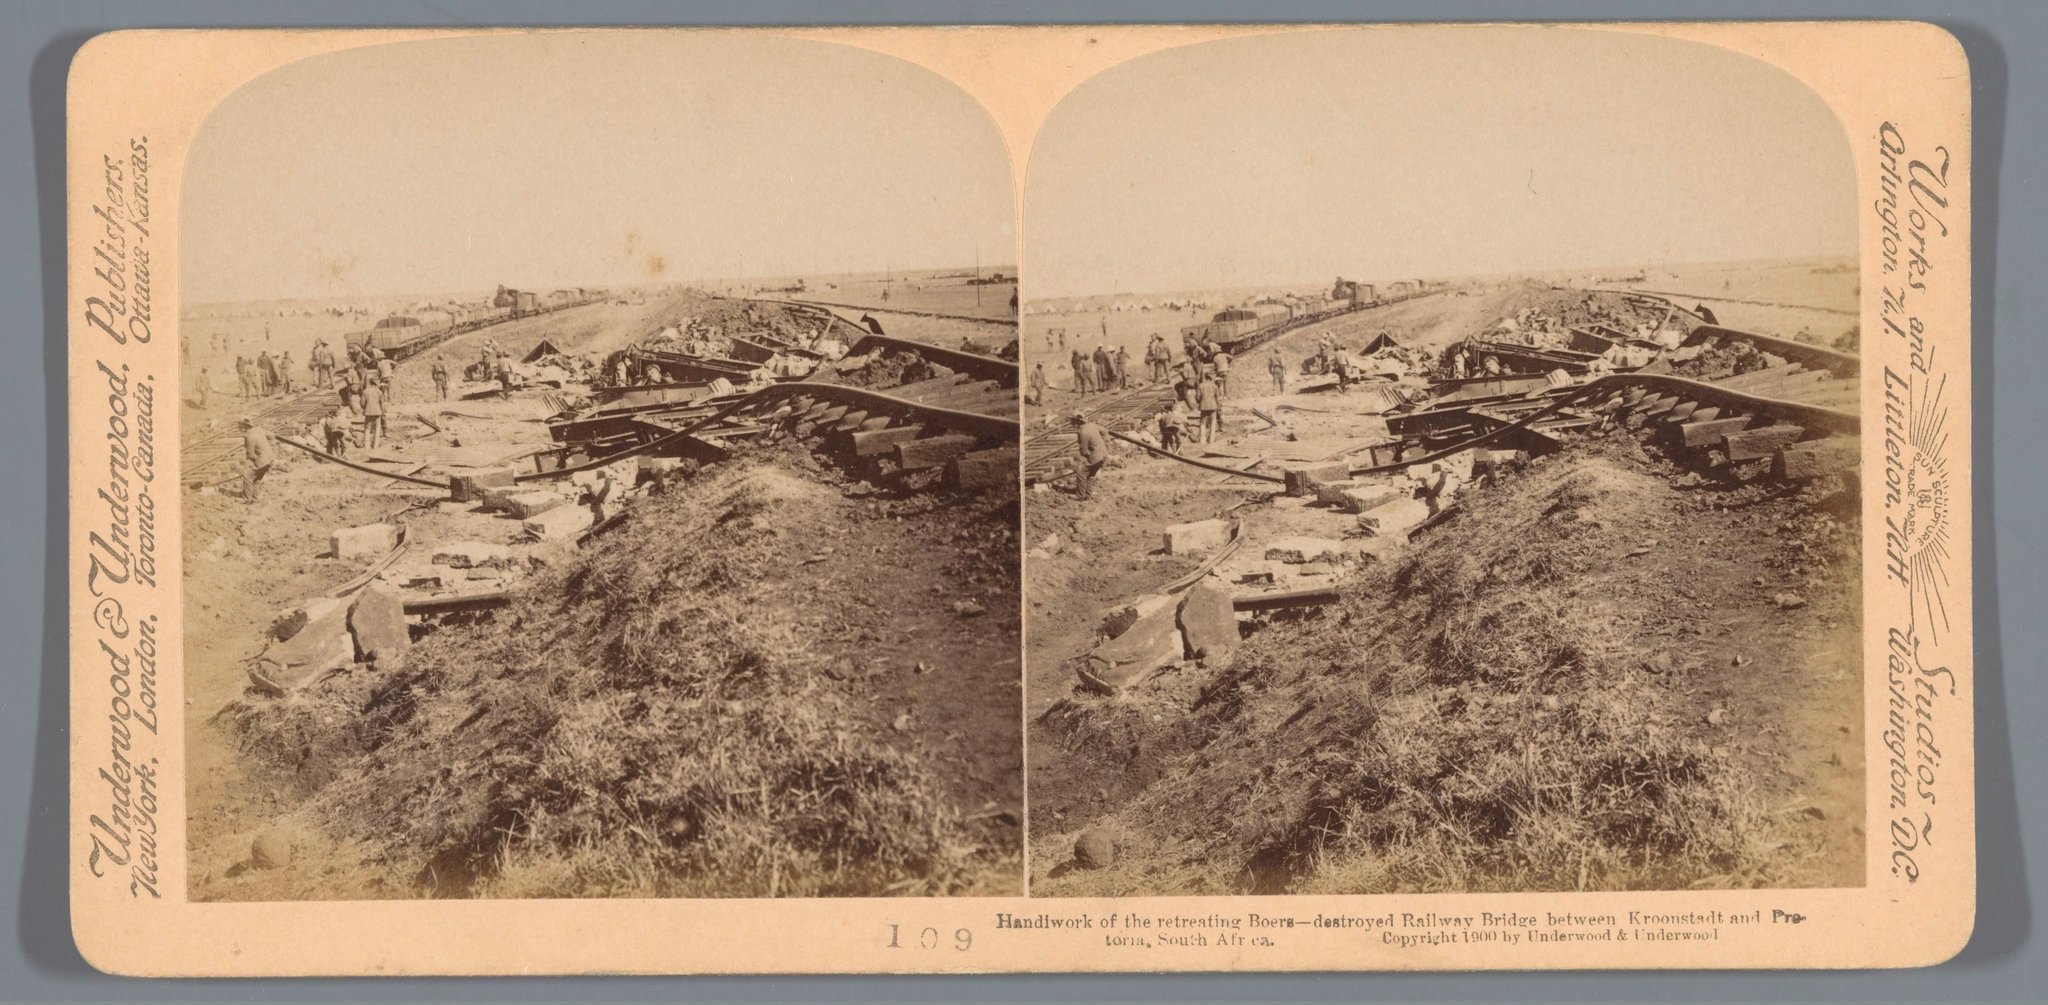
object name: stereograph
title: Handiwork of the retreating Boers - destroyed Railway Bridge between Kroonstadt and Pretoria, South Africa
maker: Anonymous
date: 1900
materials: cardboard, paper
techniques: albumen print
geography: new york city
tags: military engineering ~ communication and transport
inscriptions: inscription, copyright notice: ‘Copyright 1900 by Underwood & Underwood.’, number: ‘109’, inscription: ‘Works and Studios ~/ Arlington, N.J. Littleton, N.H. Washington, D.C.’